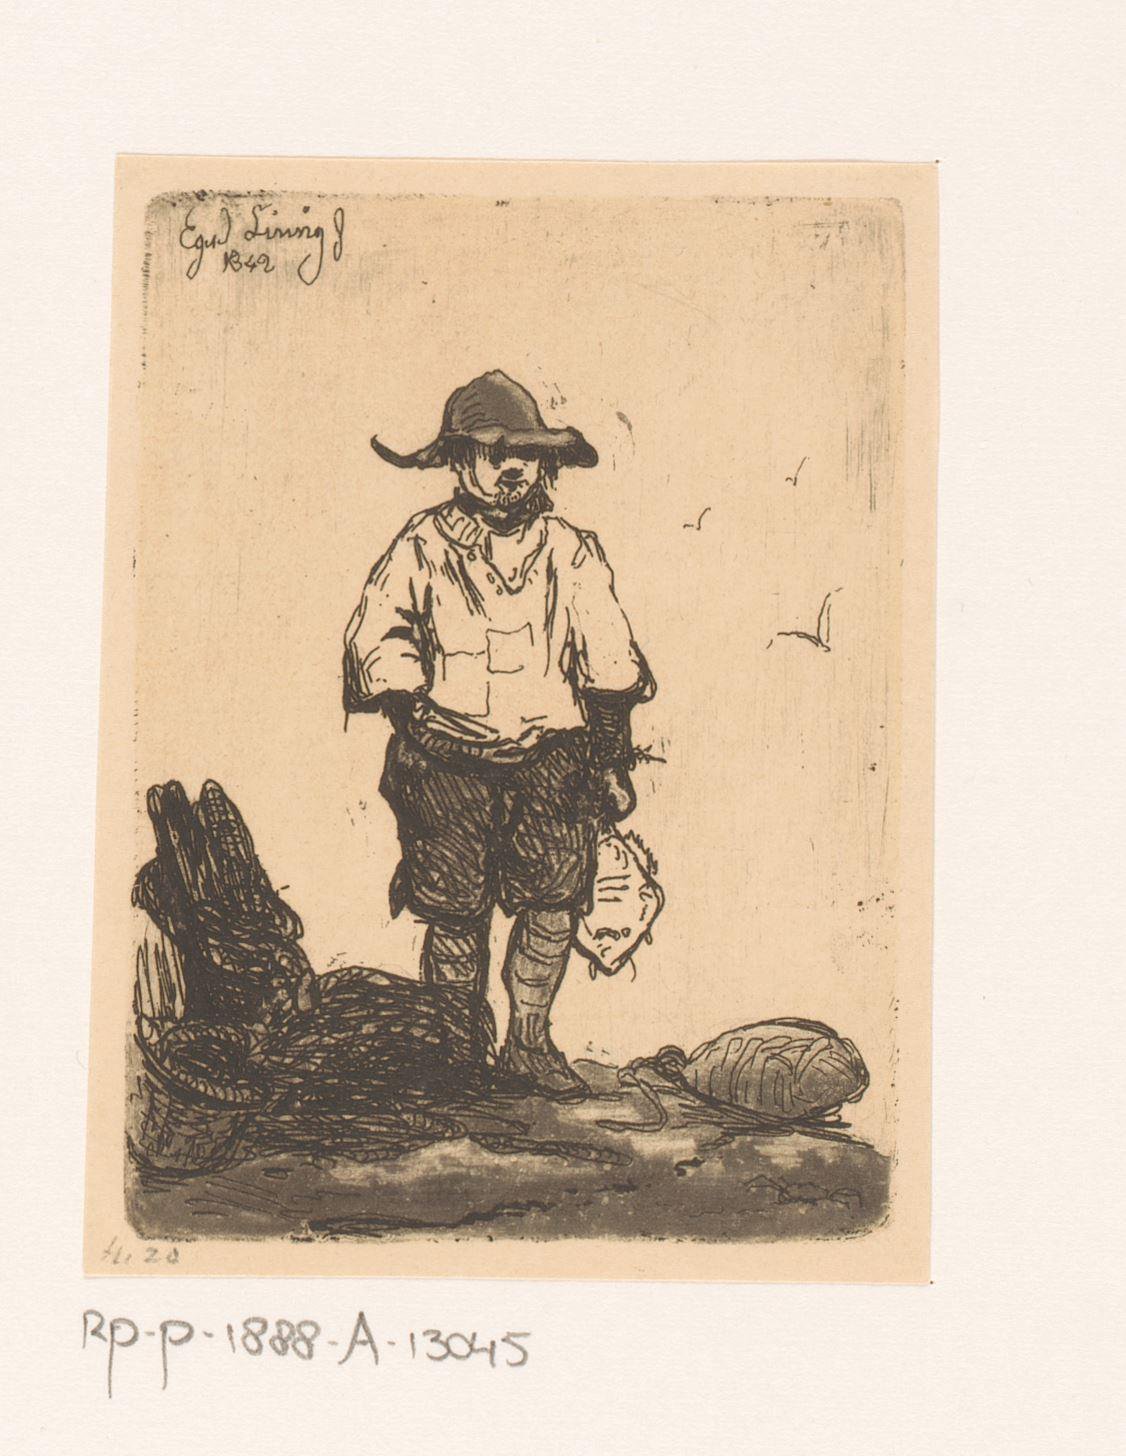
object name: print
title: Visser op rog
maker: egidius linnig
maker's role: draughtsman, print maker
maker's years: 1821-1860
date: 1842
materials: paper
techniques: aquatint, etching, intaglio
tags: cartilaginous fishes: ray, fisherman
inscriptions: collector's mark: Lugt 2228